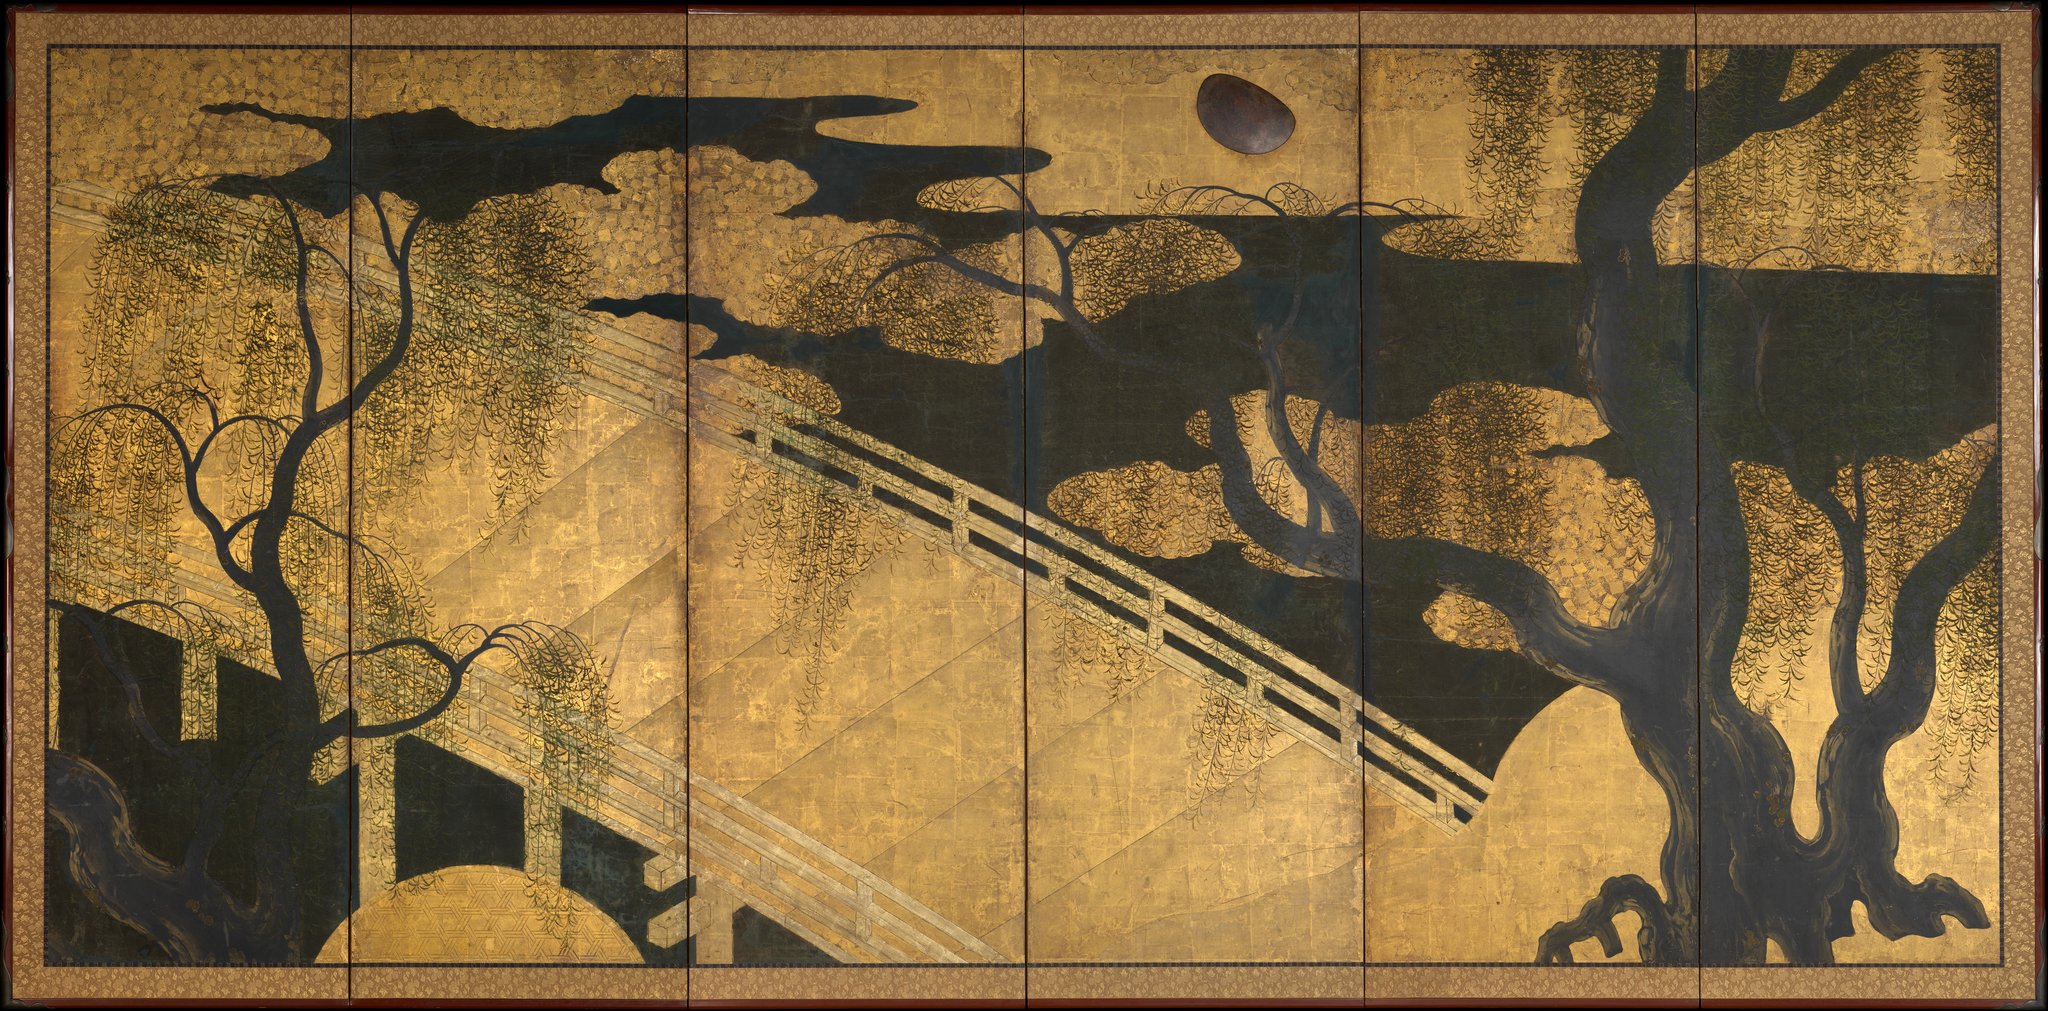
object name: screen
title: Willows and Bridge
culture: japanese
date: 1601-1633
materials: copper, gold, gold leaf, ink, panel, paper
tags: bridges,plants